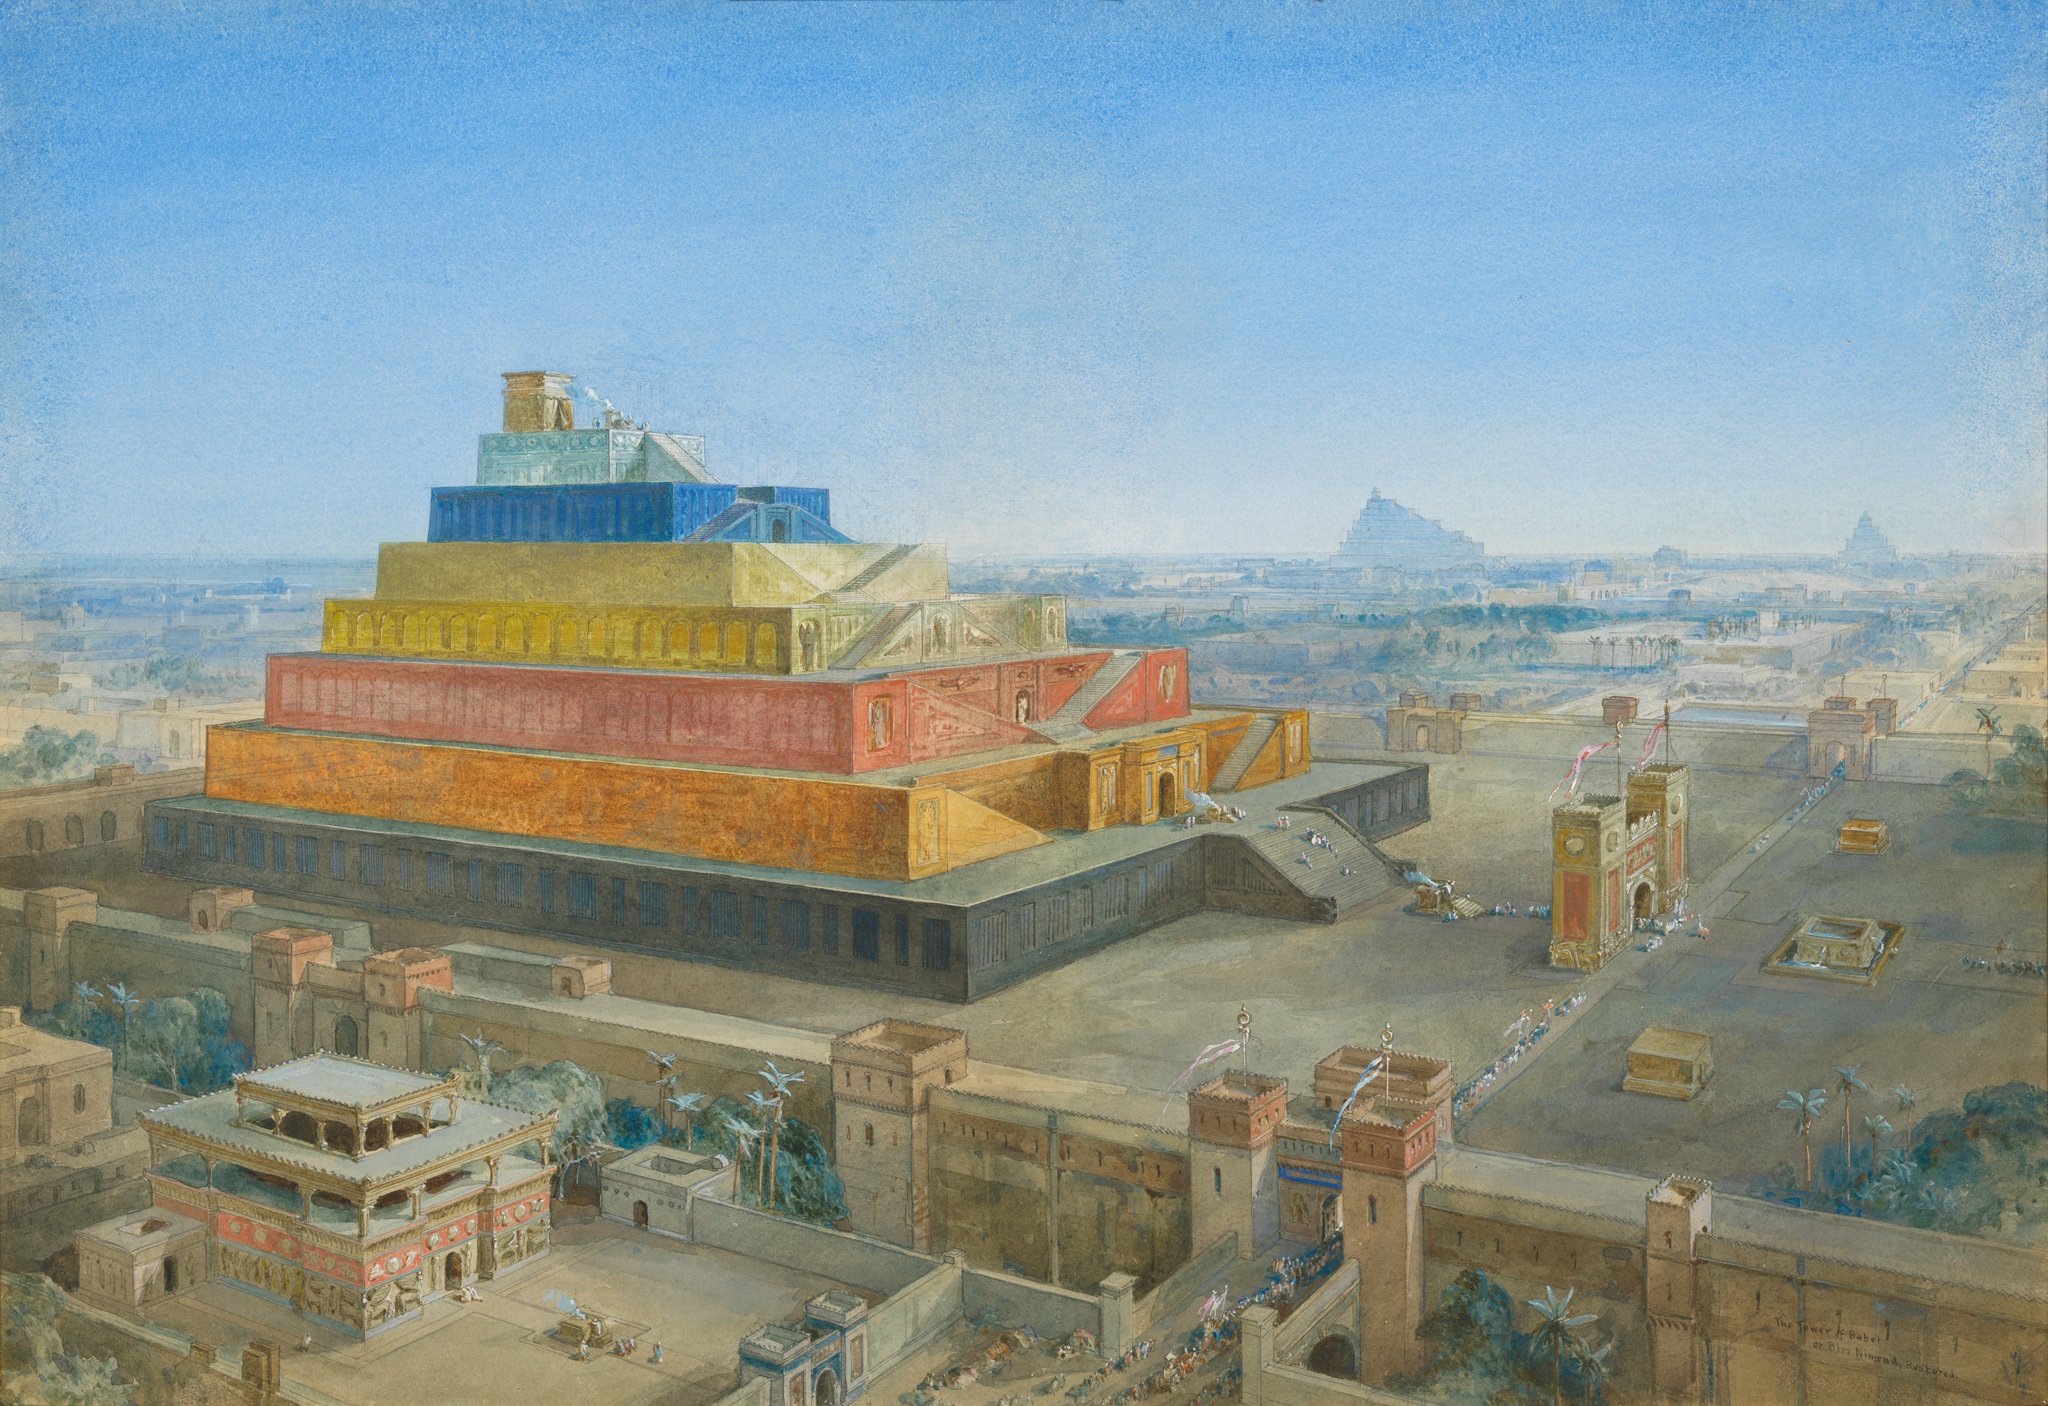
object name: drawing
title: The Tower of Babel or Birs Nimrud Restored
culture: british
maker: william simpson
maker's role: artist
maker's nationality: british, scottish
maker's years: 1823-1899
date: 1885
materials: graphite, watercolor